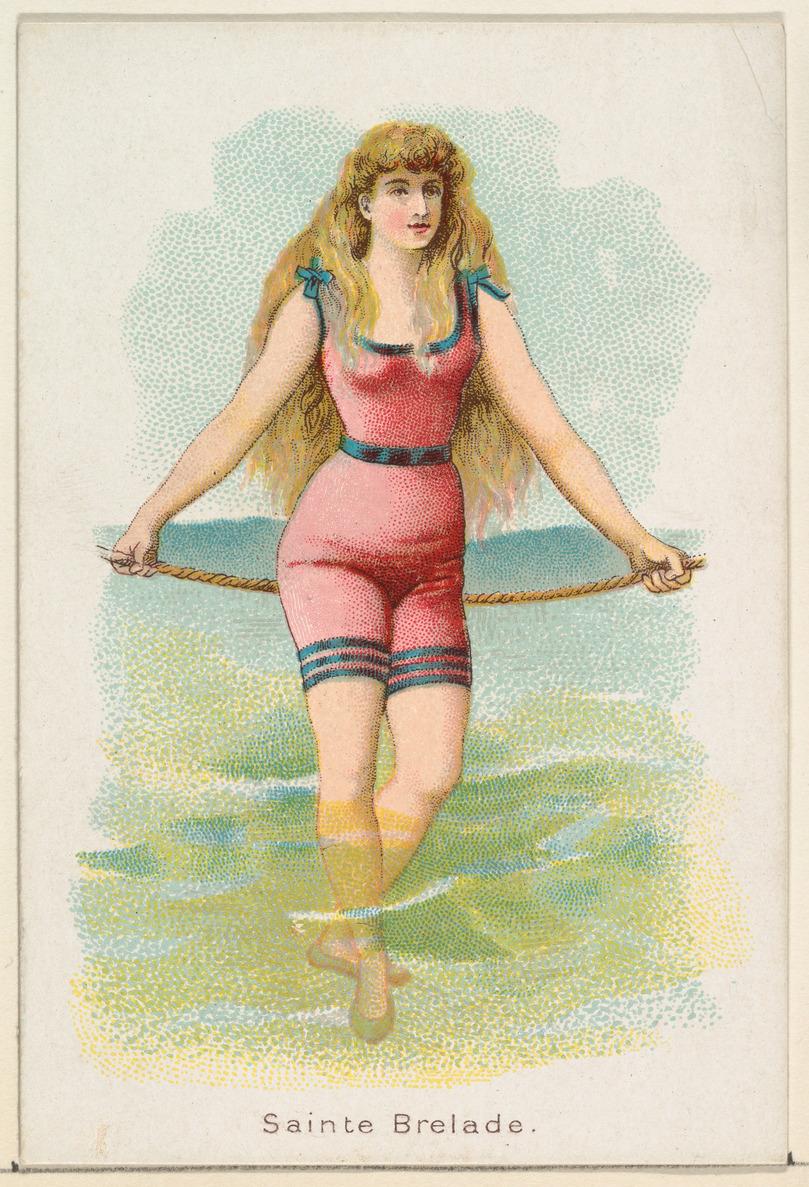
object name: print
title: Sainte Brelade, from the Beautiful Bathers series (N192) issued by Wm. S. Kimball & Co.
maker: william s. kimball & company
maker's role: publisher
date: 1889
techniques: color lithograph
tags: women